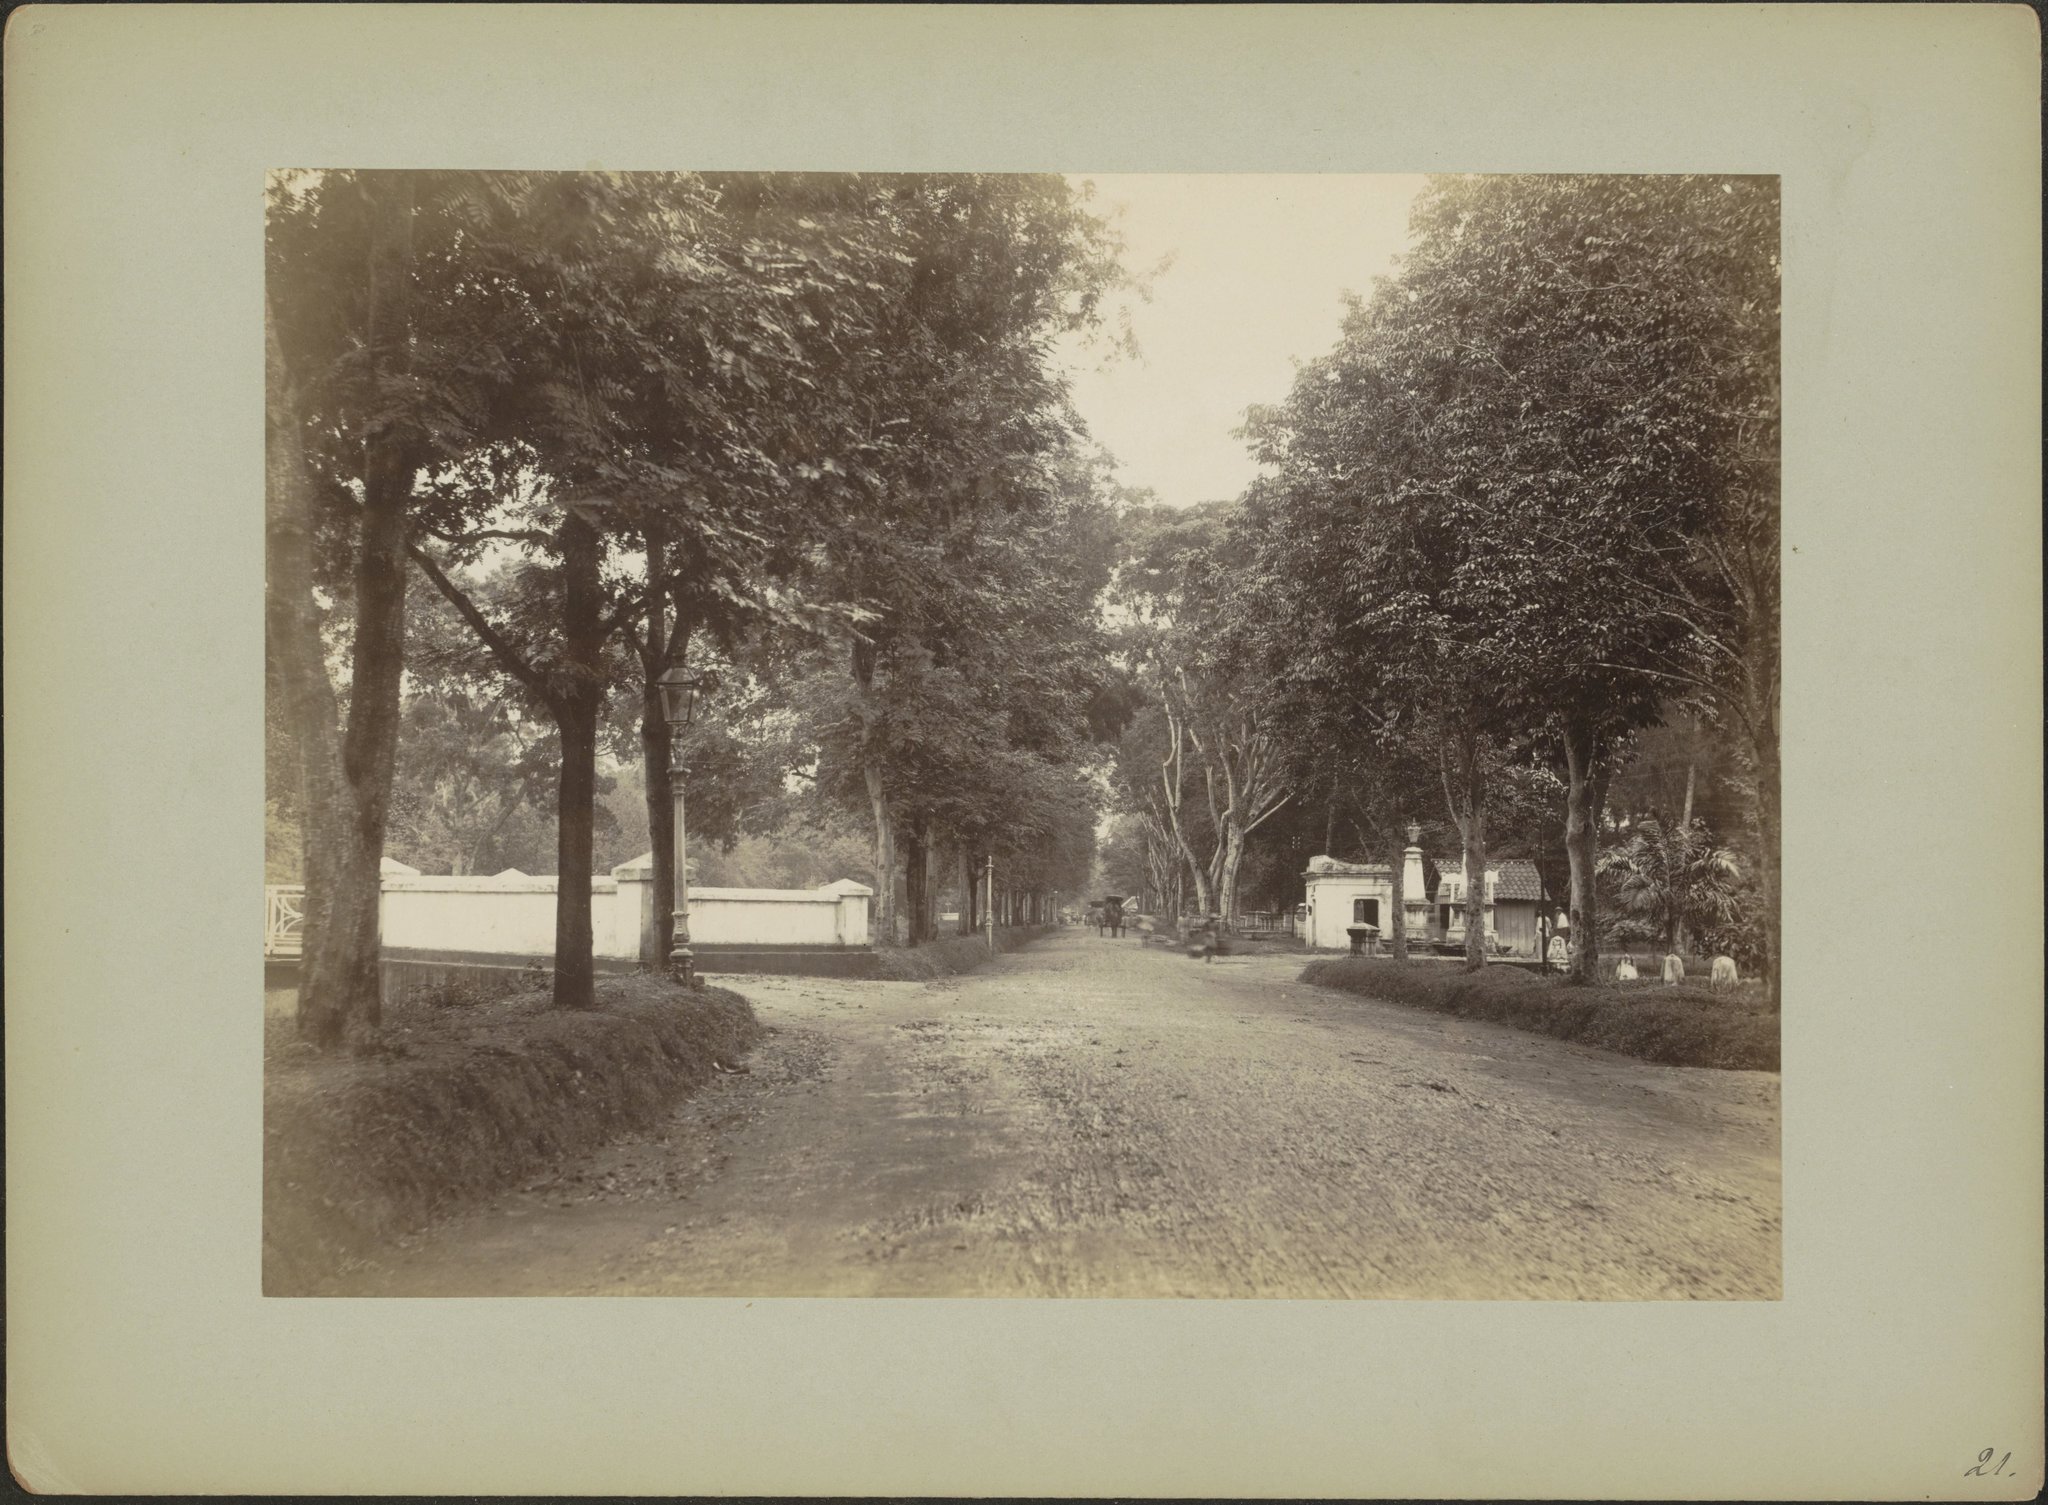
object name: photograph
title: Laan Tanah Abang met gebouwen aan weerszijden in Batavia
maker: Anonymous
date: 1870-1910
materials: cardboard, paper, photographic support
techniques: albumen print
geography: batavia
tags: lane, alley, batavia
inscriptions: inscription: ‘Zanah Abang Batavia’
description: Onderdeel van Reisalbum met foto's van bezienswaardigheden in Marseille, Port Said, Aden, Bombay, Colombo, Singapore en Nederlands-Indië.